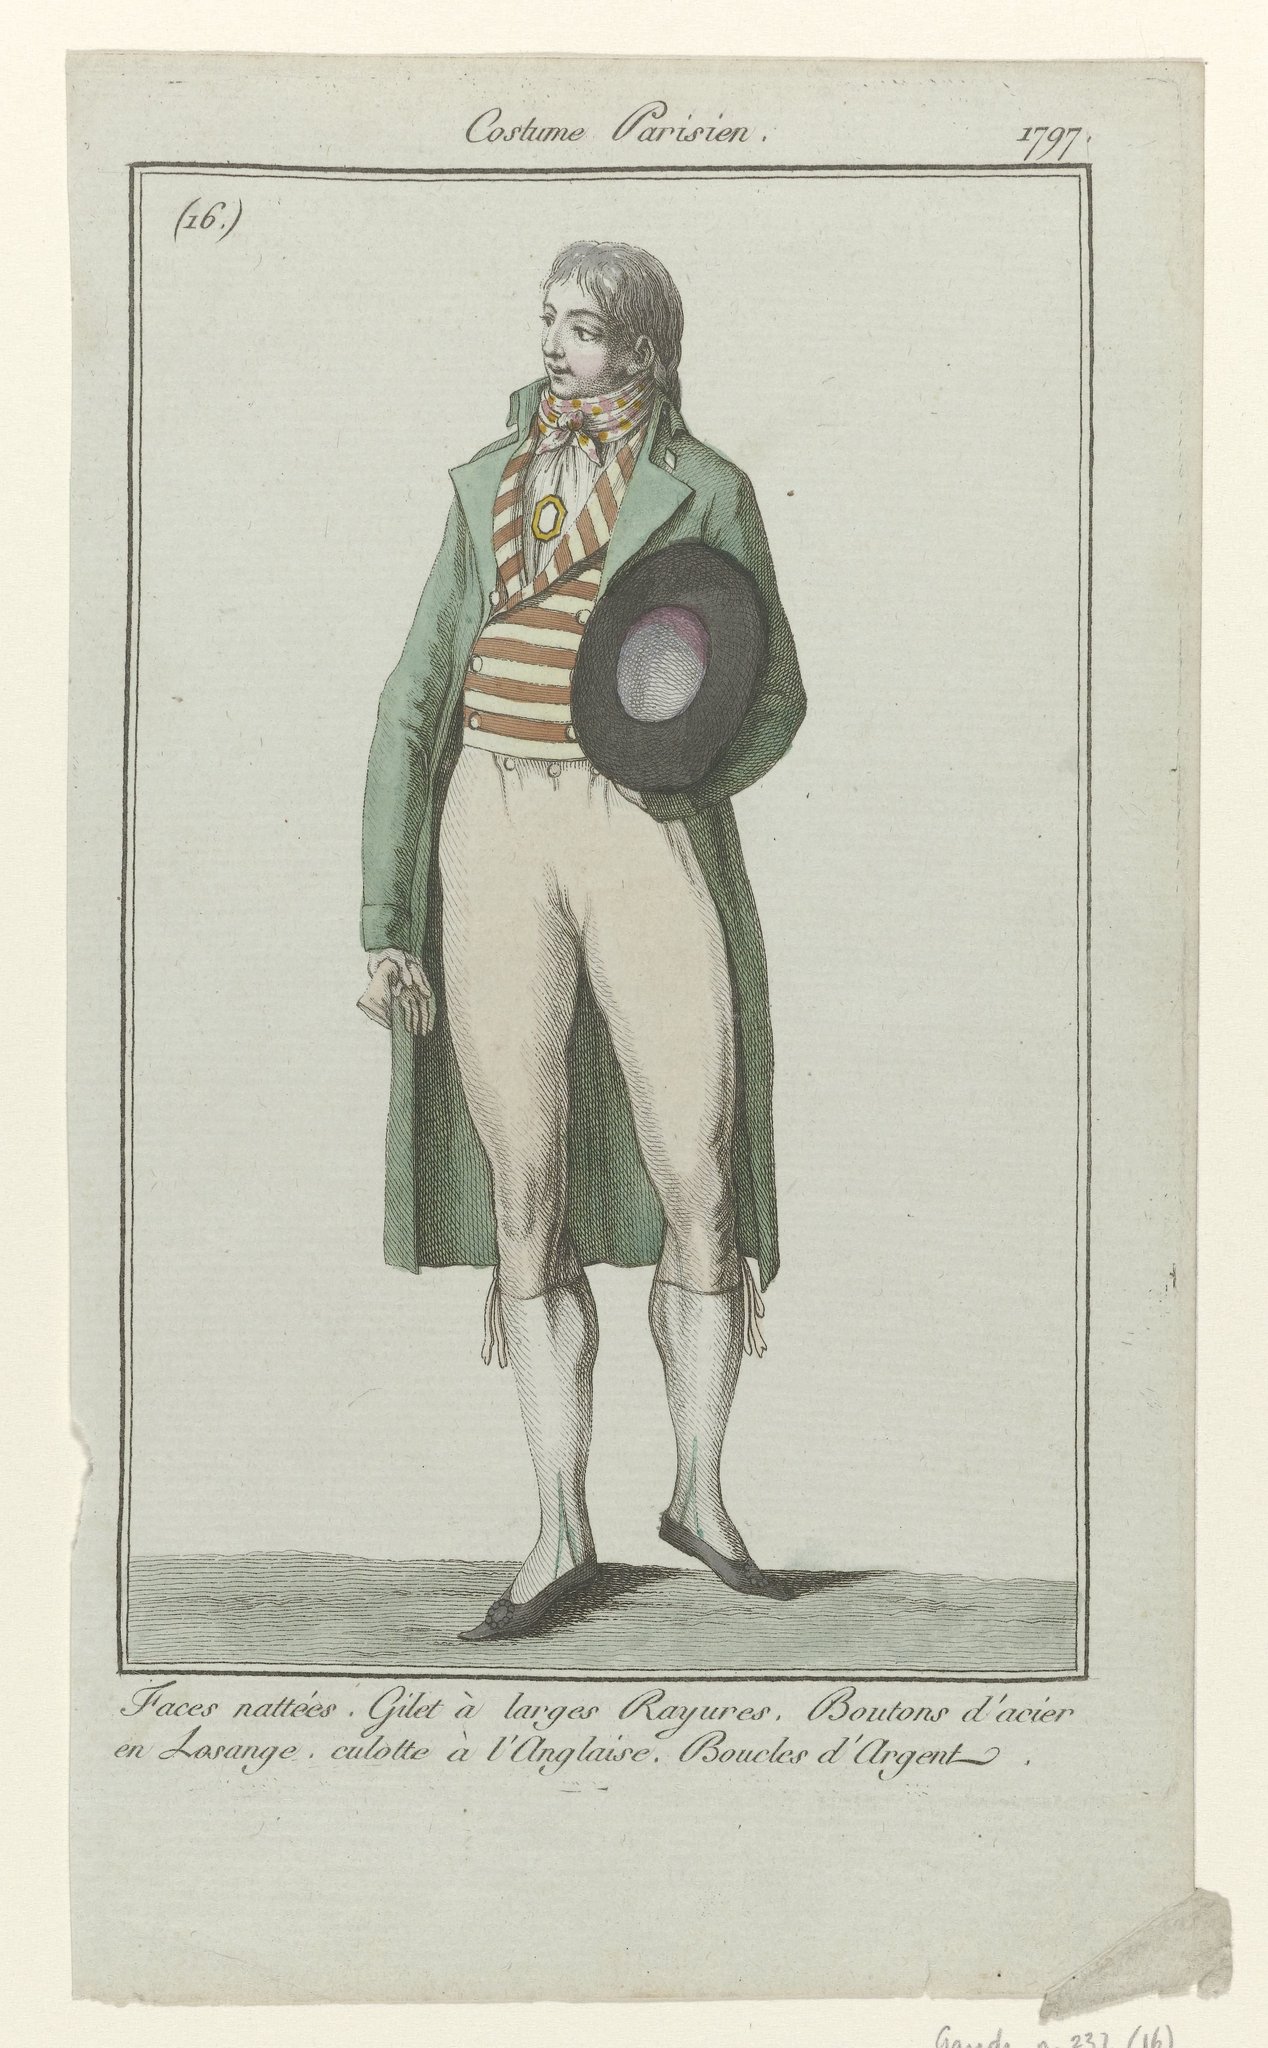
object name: fashion print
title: Journal des Dames et des Modes: Men’s Fashion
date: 1797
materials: paper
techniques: engraving, hand coloring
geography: paris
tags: clothing for the upper part of the body (vest) (+ men's clothes), neck-gear ~ clothing (cravat) (+ men's clothes), button (+ men's clothes), coat (+ men's clothes), head-gear: hat (+ men's clothes), styles of hairdress, fashion plates, shoes, sandals (+ men's clothes), trousers, breeches, etc. (breeches) (+ men's clothes), gloves, mittens, etc. (+ men's clothes), stockings, socks (+ men's clothes), buckle (+ men's clothes)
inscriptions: title: ‘Costume Parisien.’, caption: ‘Faces nattées, Gilet à larges Rayures. Boutons d'acier en Losange, culotte à L'Anglaise. Boucles d'Argent.’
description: The Journal des Dames et des Modes occasionally provided coverage of men’s styles. These illustrations give a good picture of trends in mens’ clothing from 1797 to 1825. During the 18th century, gentlemen wore culotte (knee-breeches) 1. These fell out of fashion with the elimination of strict class distinctions during the French Revolution, to be replaced by a type of long trouser(s) known as pantalon à la Hussarde 2. These were worn with hussar boots. ‘Pantaloons’ 3 were trousers pulled tight with an elastic strap under the instep. Carrick 4 coats with a double collar were popular, and in the evenings men wore a special dress cloak 5.